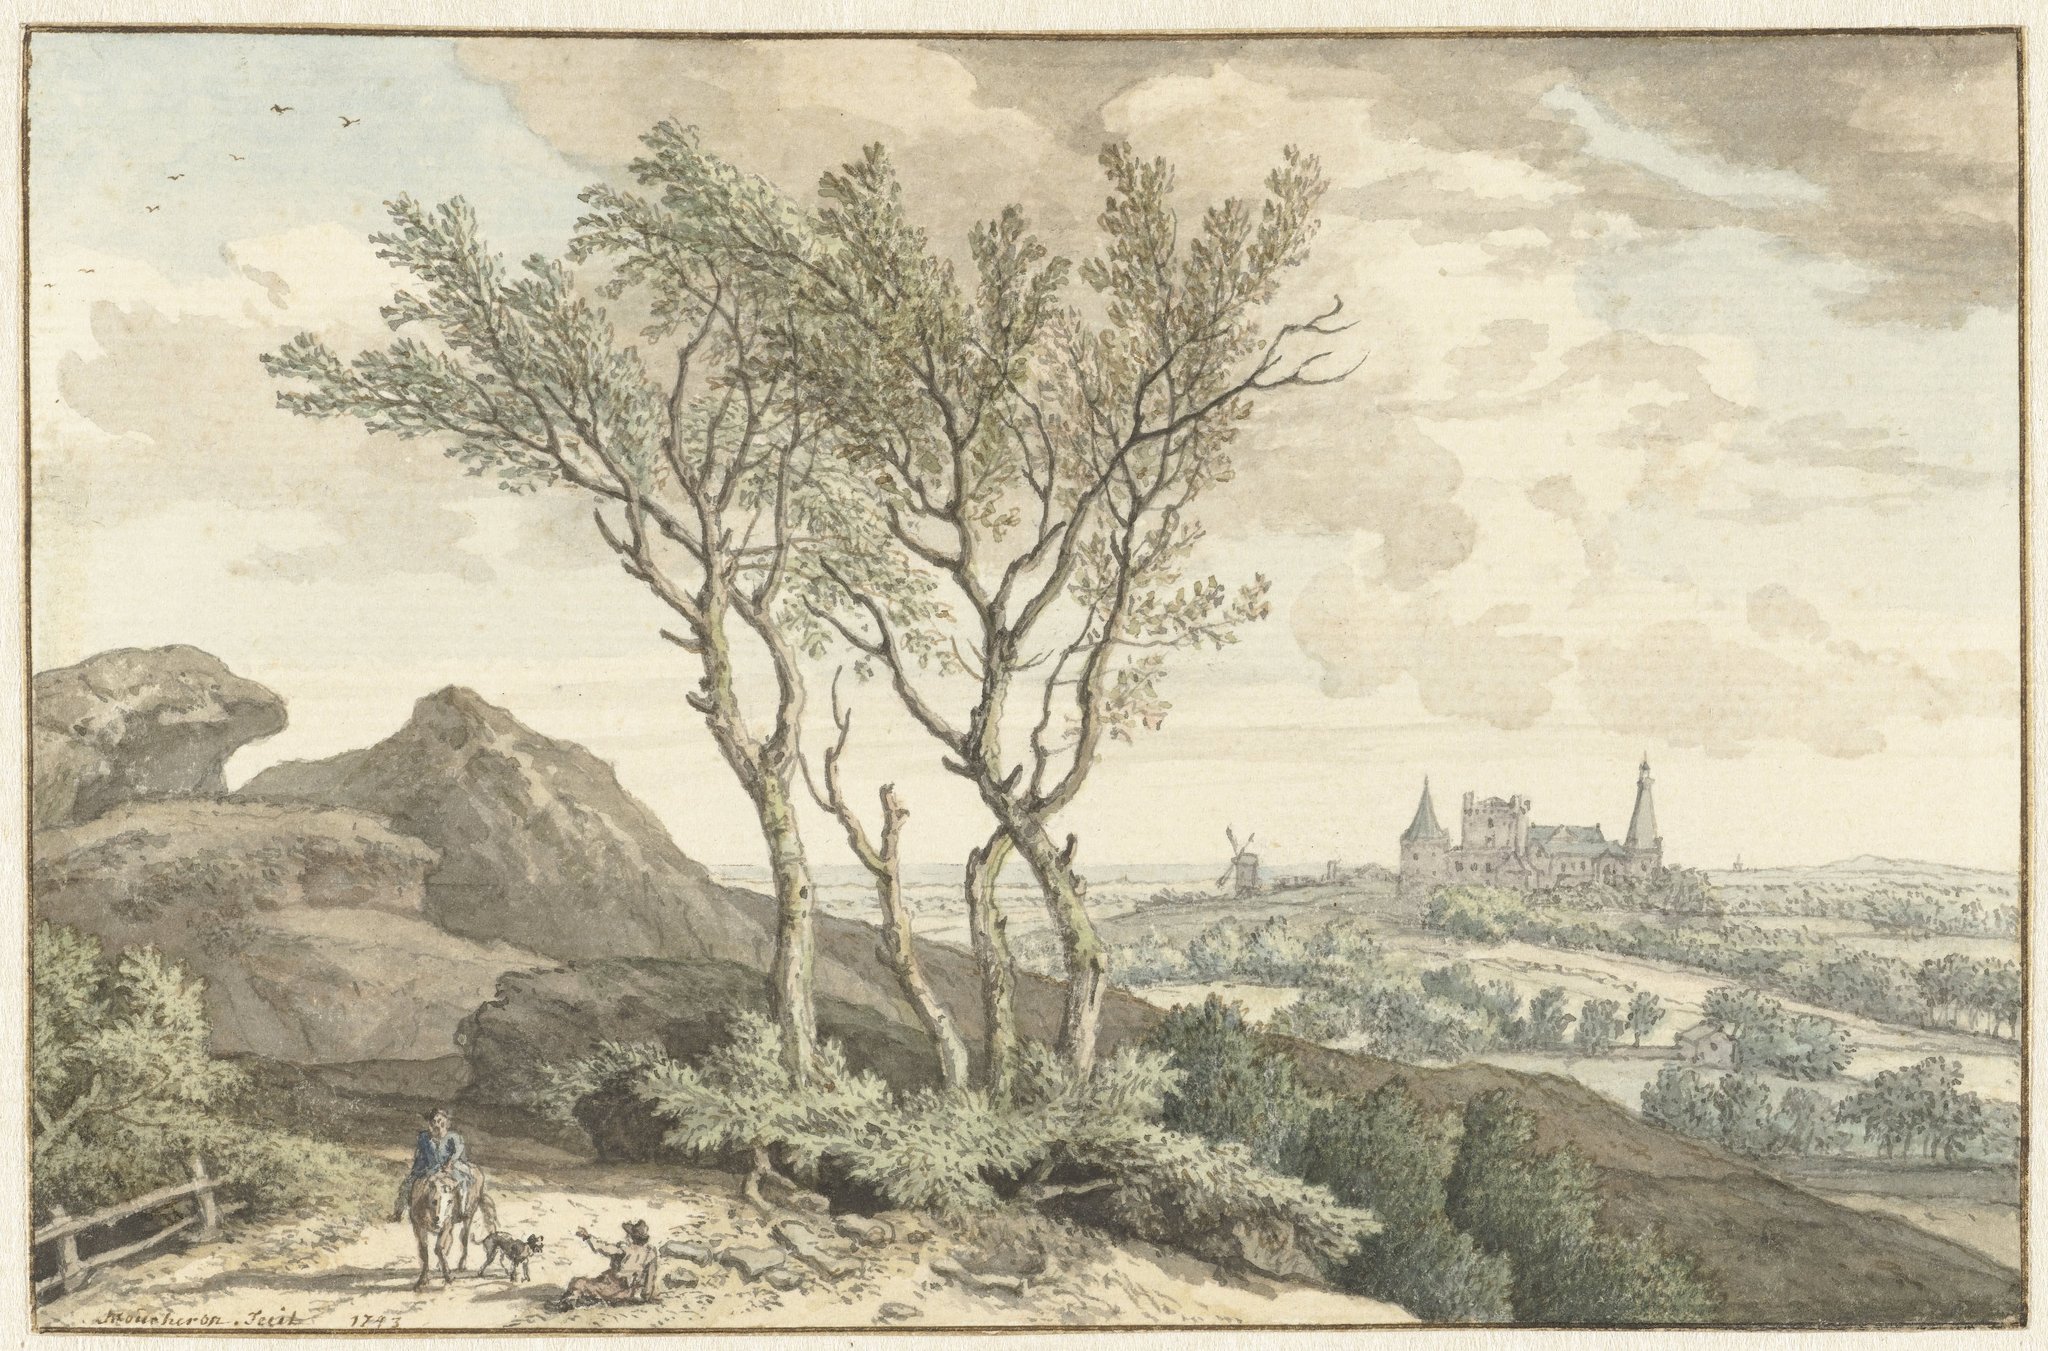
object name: watercolor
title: Gezicht op het kasteel van Bentheim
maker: isaac de moucheron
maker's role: draughtsman, painter, print maker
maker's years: 1667-1744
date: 1743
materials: ink, paper, watercolor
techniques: brush, pen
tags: castle, germany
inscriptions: inscription: ‘Gezicht naar 't huys te Bentheim (?)’